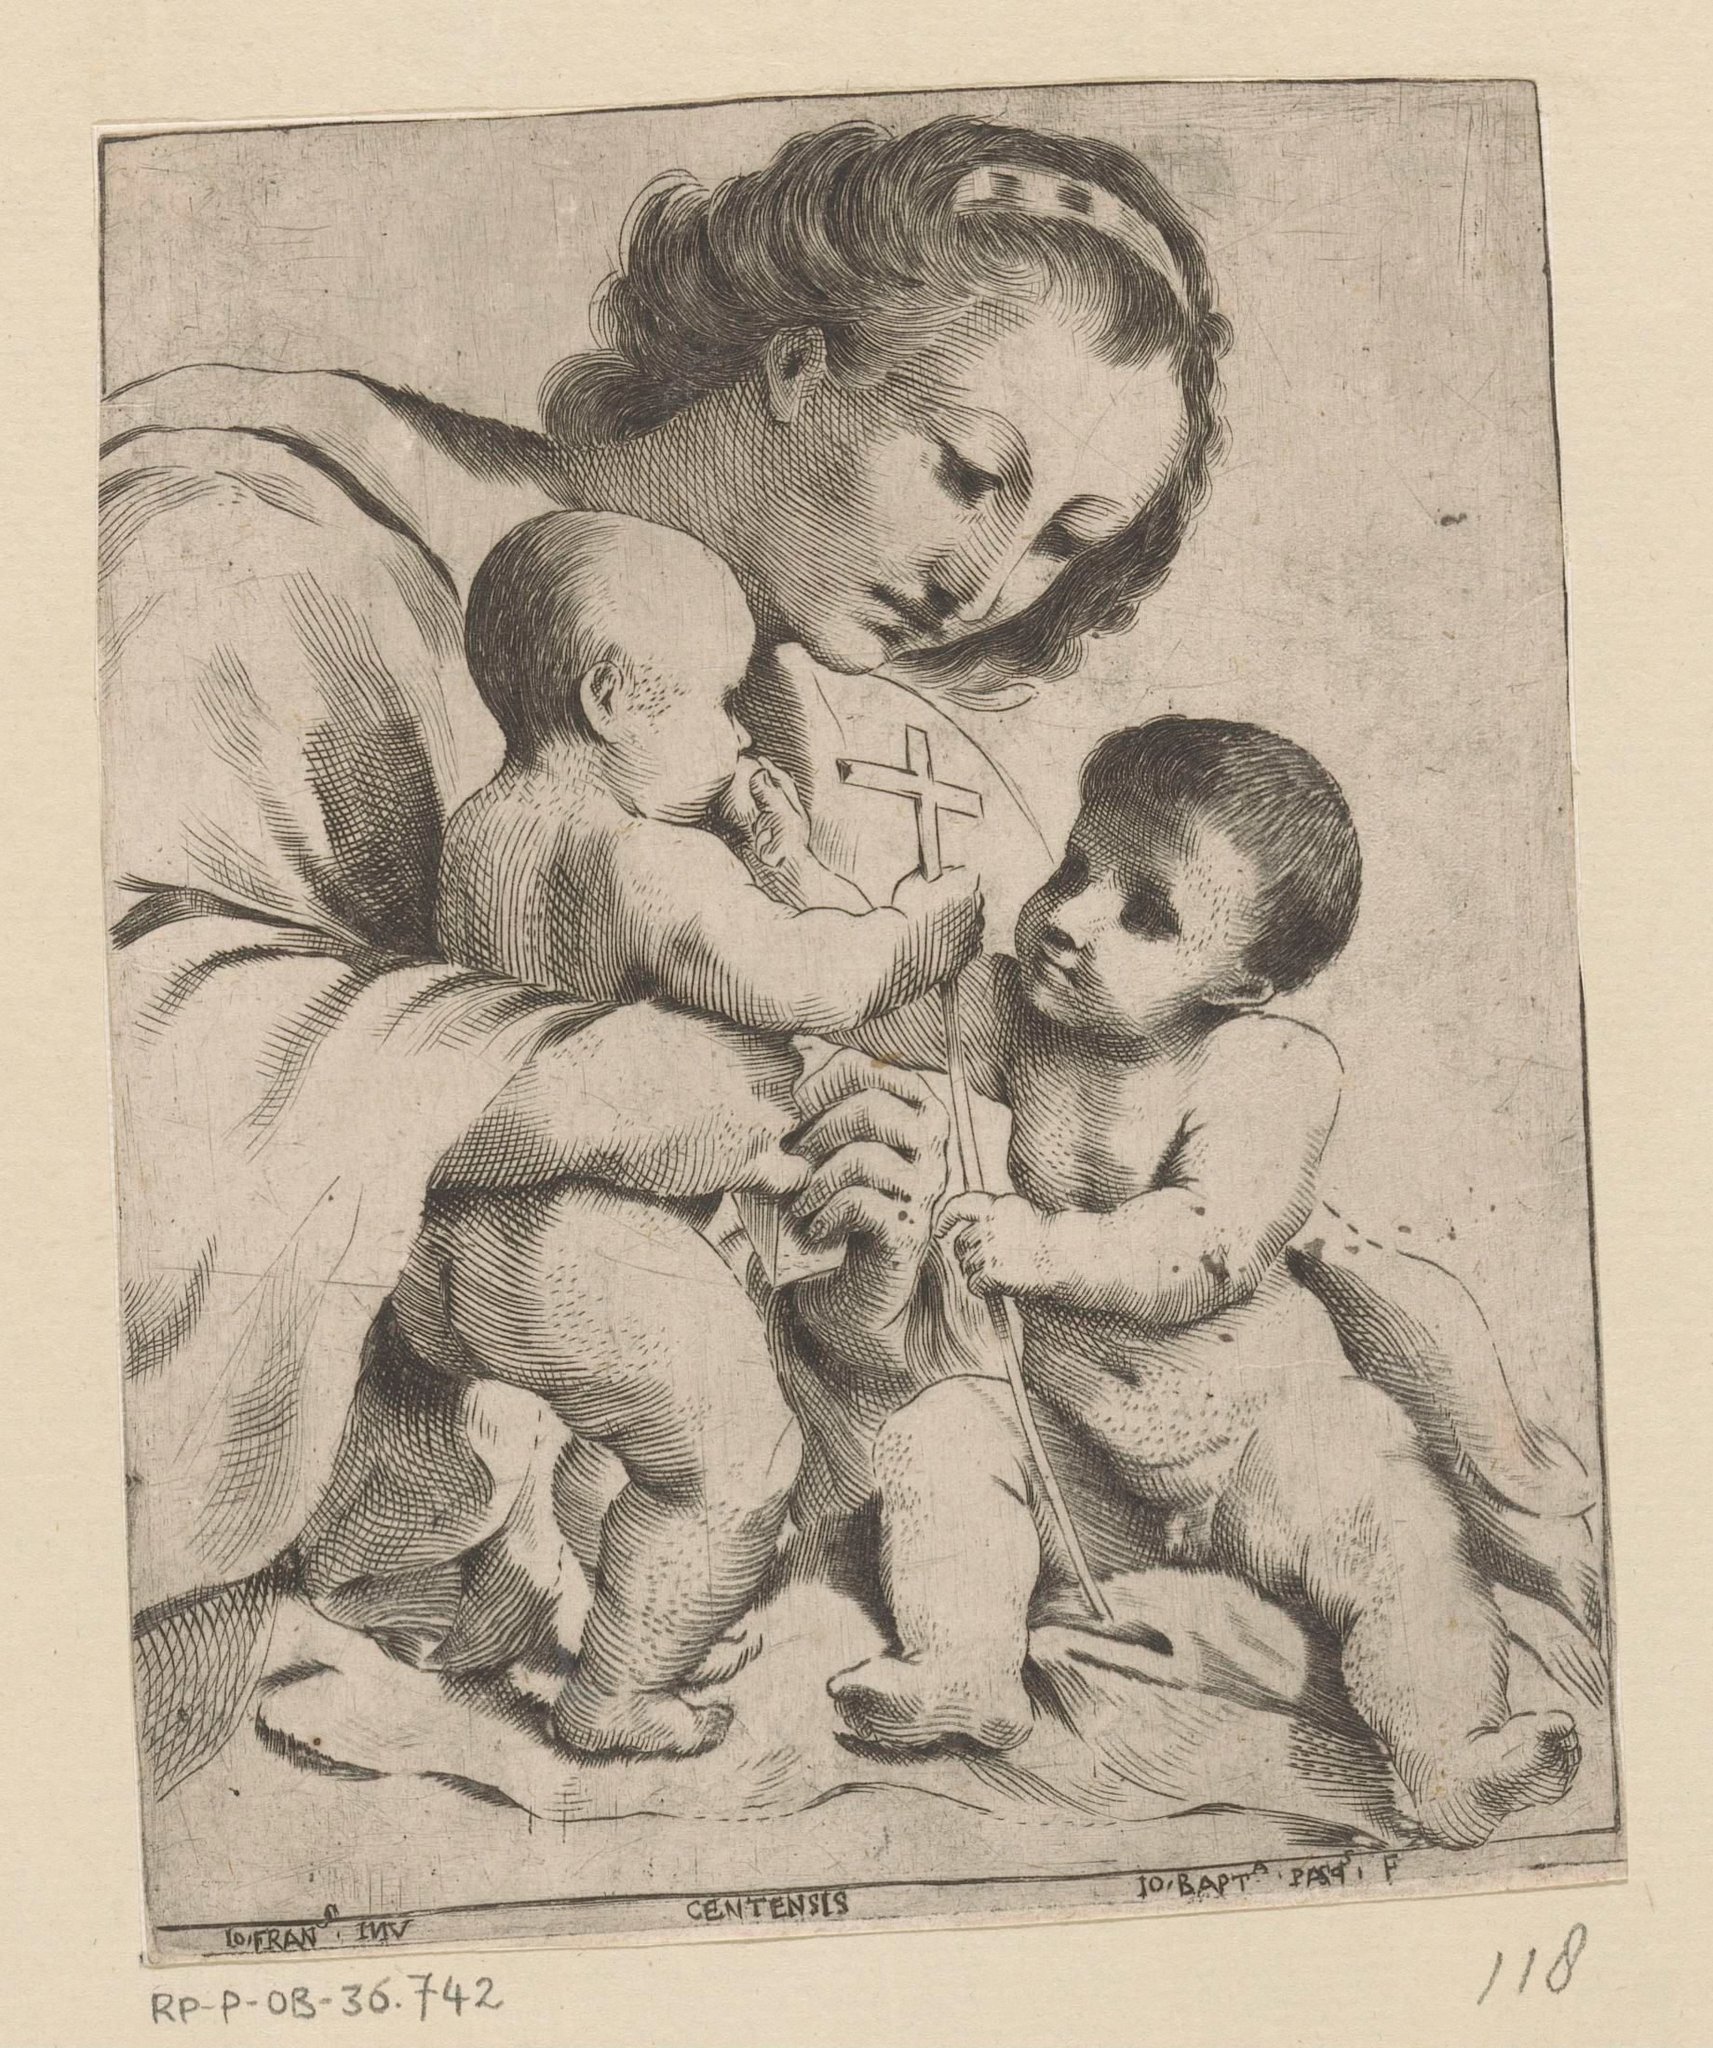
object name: print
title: Maria met Kind en de jonge Johannes de Doper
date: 1601-1634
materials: paper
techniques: engraving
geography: italy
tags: mary and the christ-child with john the baptist (as child)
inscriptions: collector's mark: Lugt 240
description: Maria met het Christuskind en de jonge Johannes de Doper met het kruis.